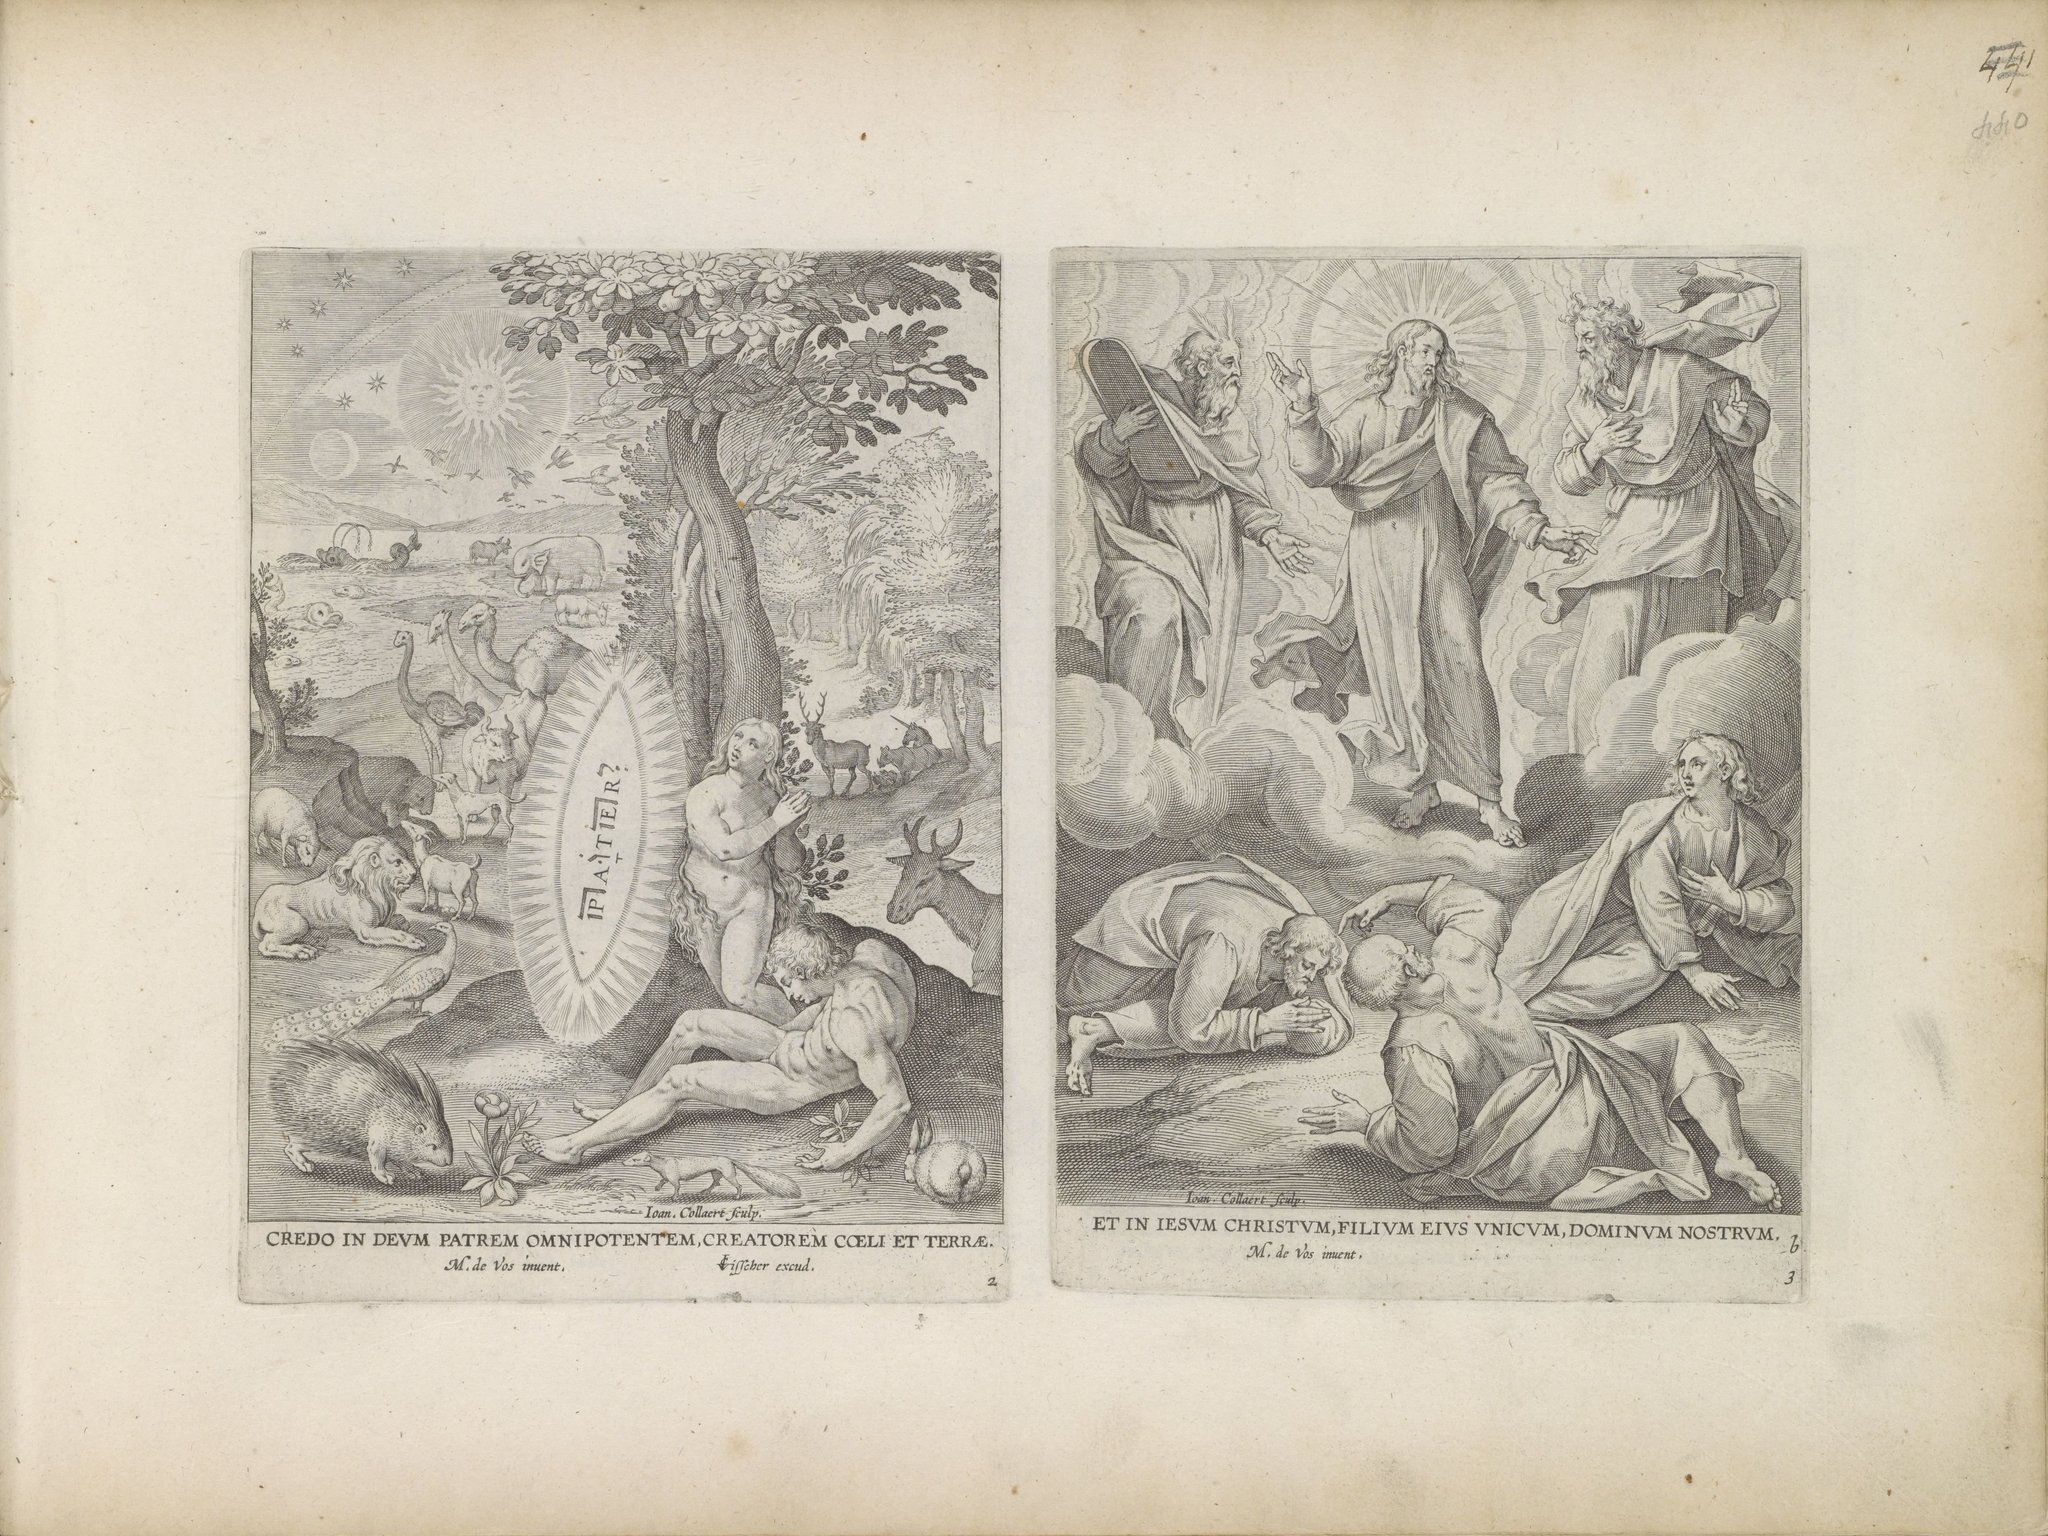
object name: print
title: Credo in Deum Patrem omnipotentem creatorem coeli et terrae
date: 1570-1618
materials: paper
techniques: engraving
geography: amsterdam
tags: 'credo in deum patrem omnipotentem, creatorem coeli et terrae' ~ articles of faith, eve emerges from adam's body, the six days of creation (genesis 1:3-25)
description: Illustratie van het eerste geloofsartikel (Ik geloof in God, de almachtige Vader, Schepper van hemel en aarde) van de apostolische geloofsbelijdenis. God de Vader schept Eva uit Adams rib. Op de achtergrond de hele schepping. Deze prent maakt deel uit van een album.